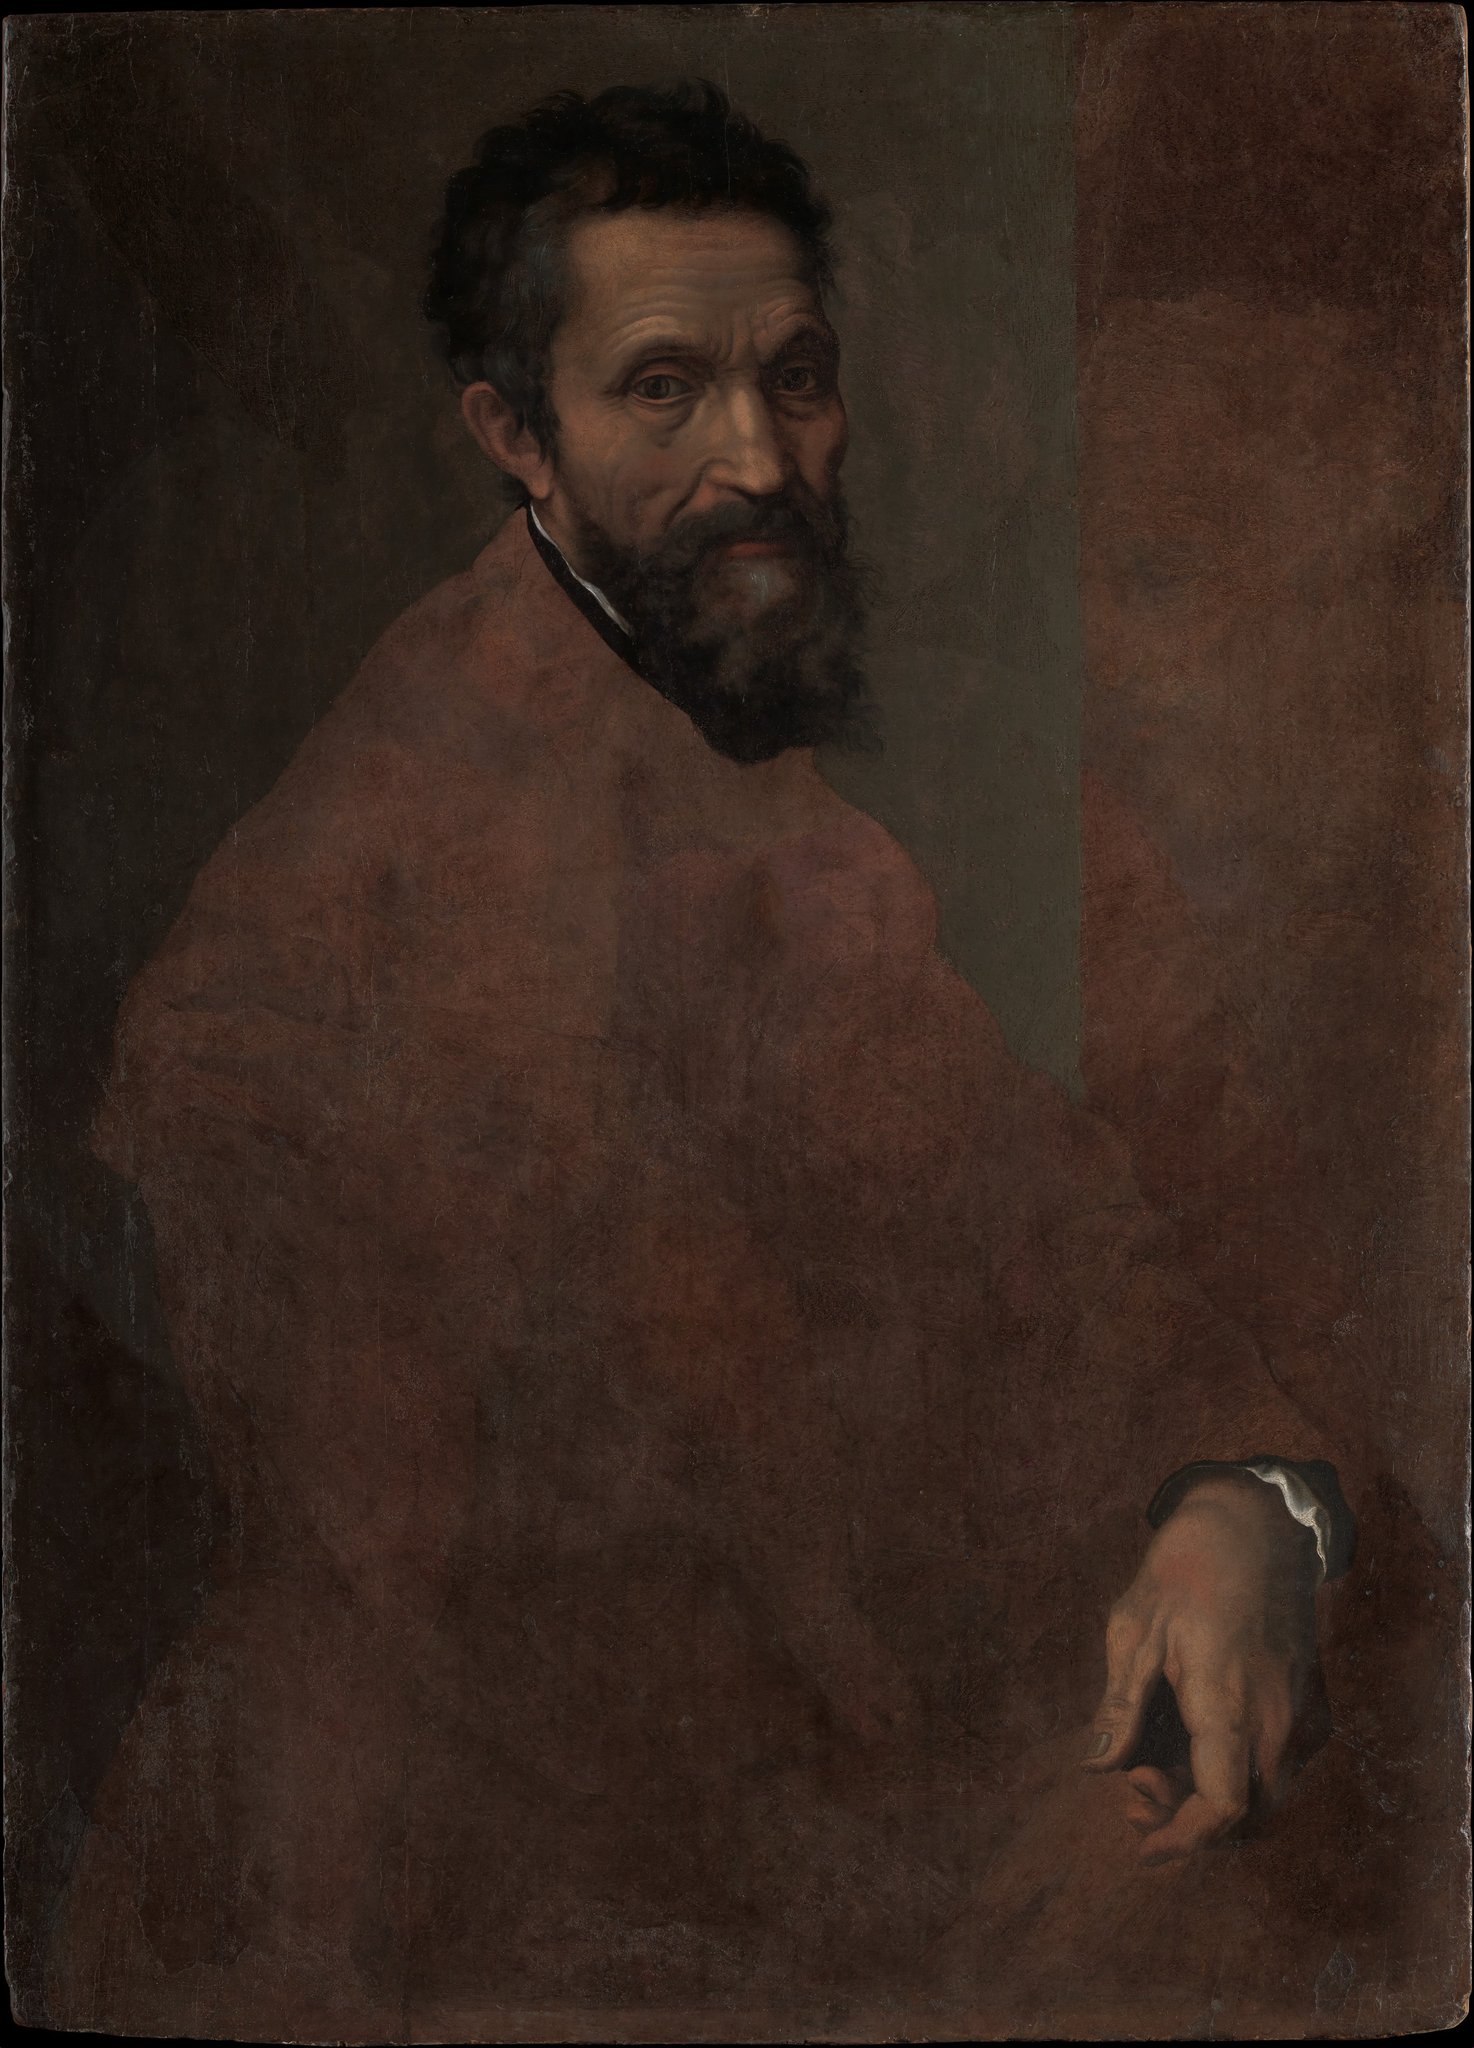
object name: painting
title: Michelangelo Buonarroti (1475–1564)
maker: daniele da volterra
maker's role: artist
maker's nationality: italian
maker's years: 1509-1566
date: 1545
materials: oil, wood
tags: men,portraits,artists